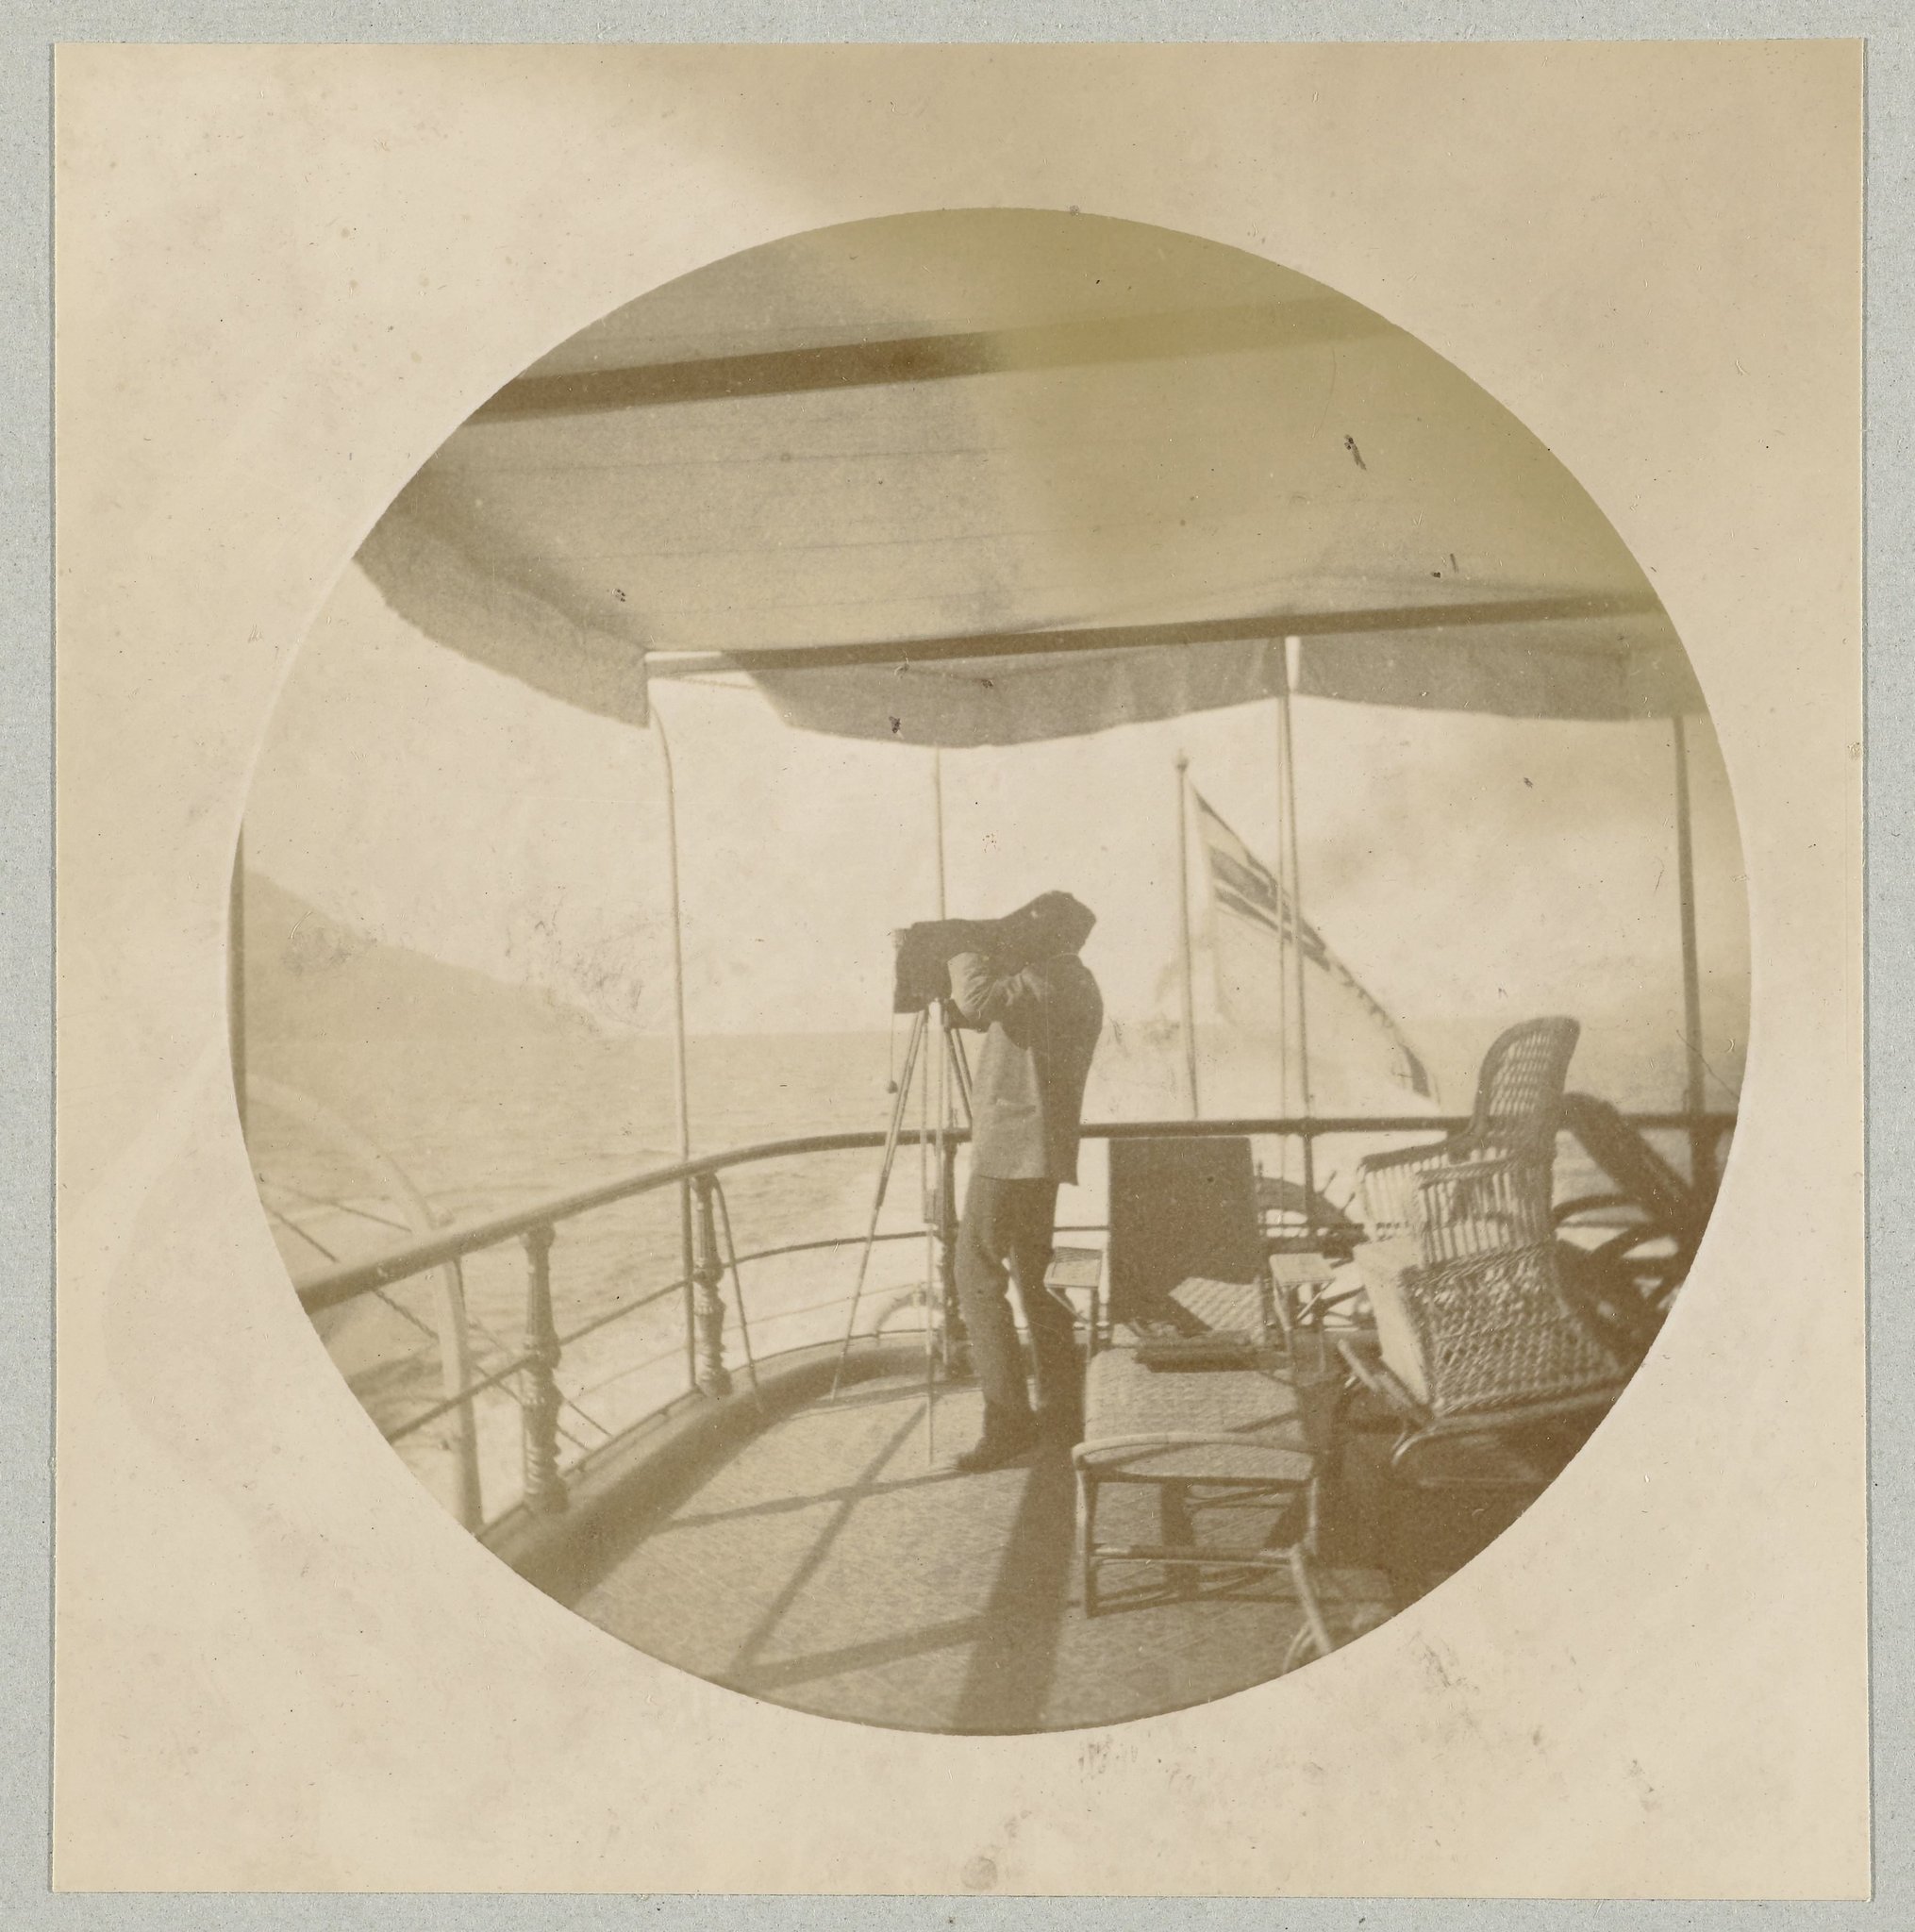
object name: photograph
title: Fotograaf aan boord van de Hohenzollern tijdens het maken van een foto op ze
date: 1807-1889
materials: cardboard, paper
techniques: gelatin silver print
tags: wilhelm ii (keizer van duitsland), norway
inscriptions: number: ‘1a’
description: De foto is rond maar is afgedrukt op vierkant papier